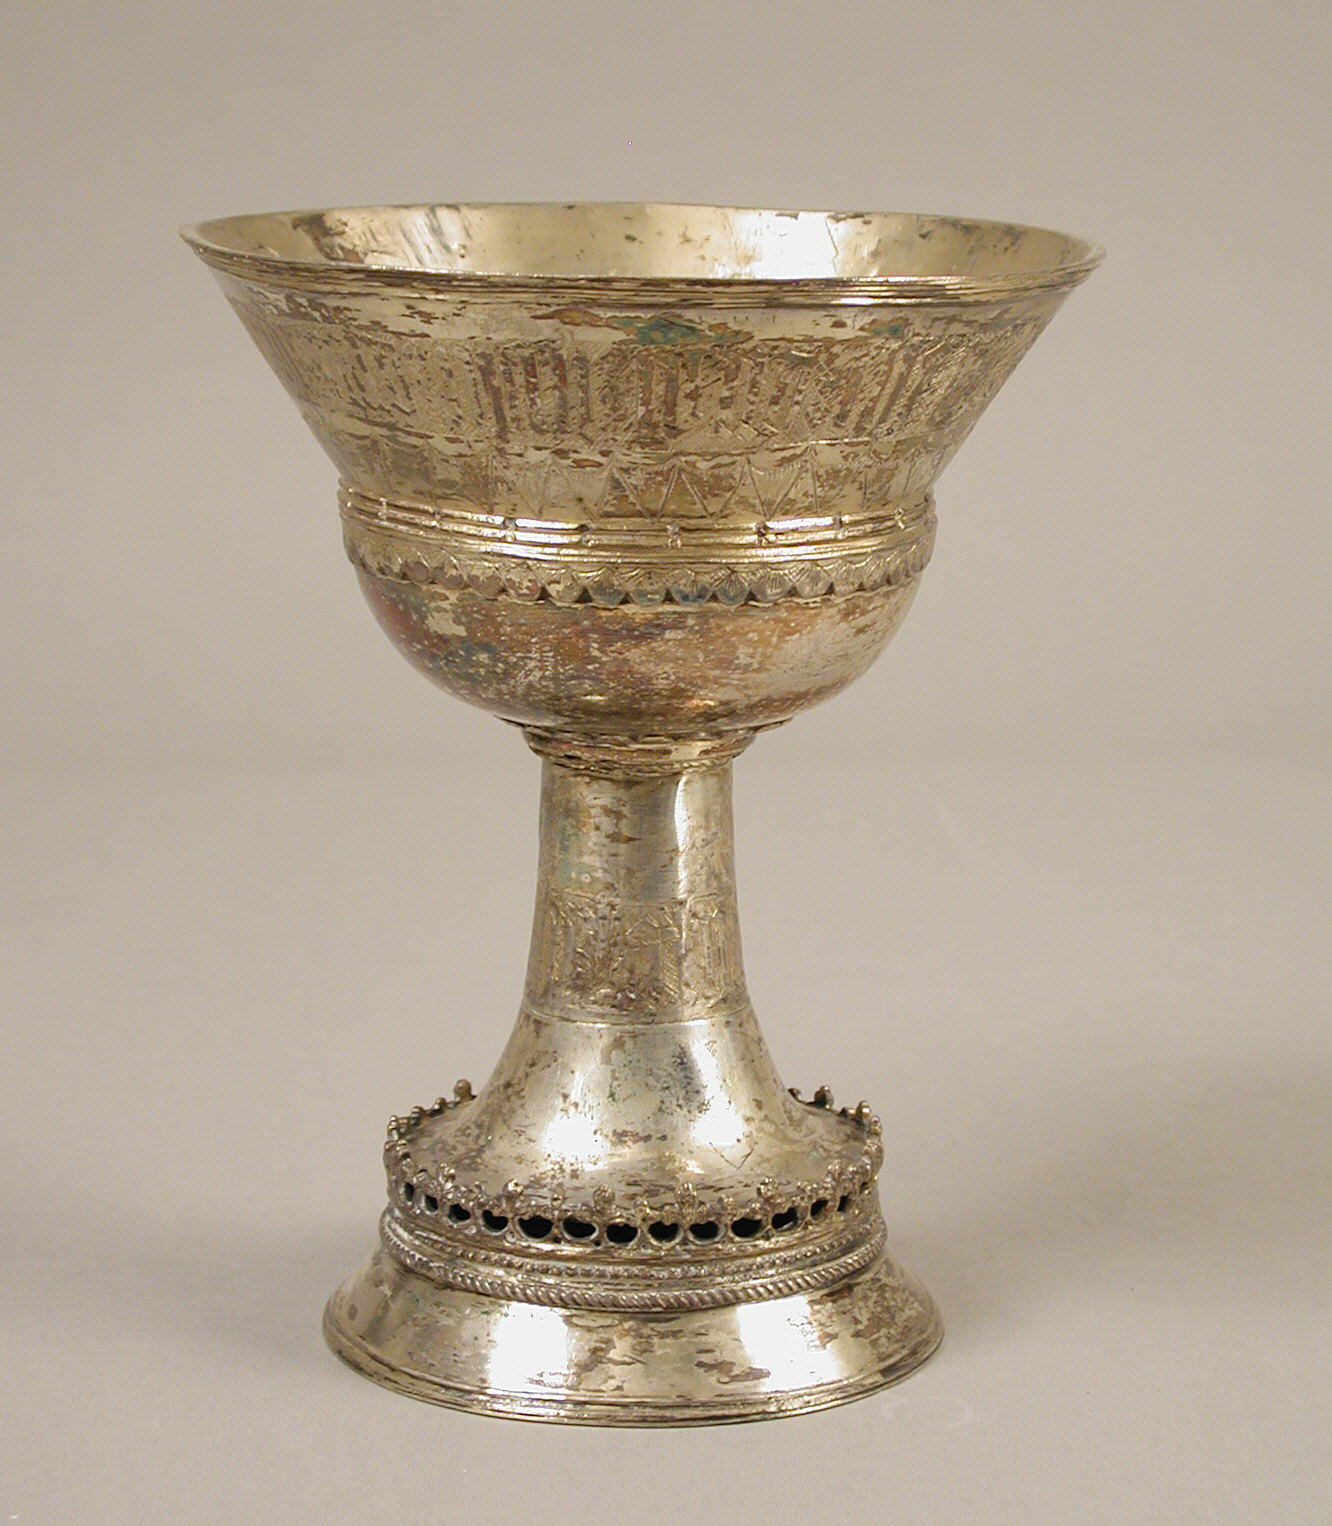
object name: cup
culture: british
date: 1901-1933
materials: silver gilt